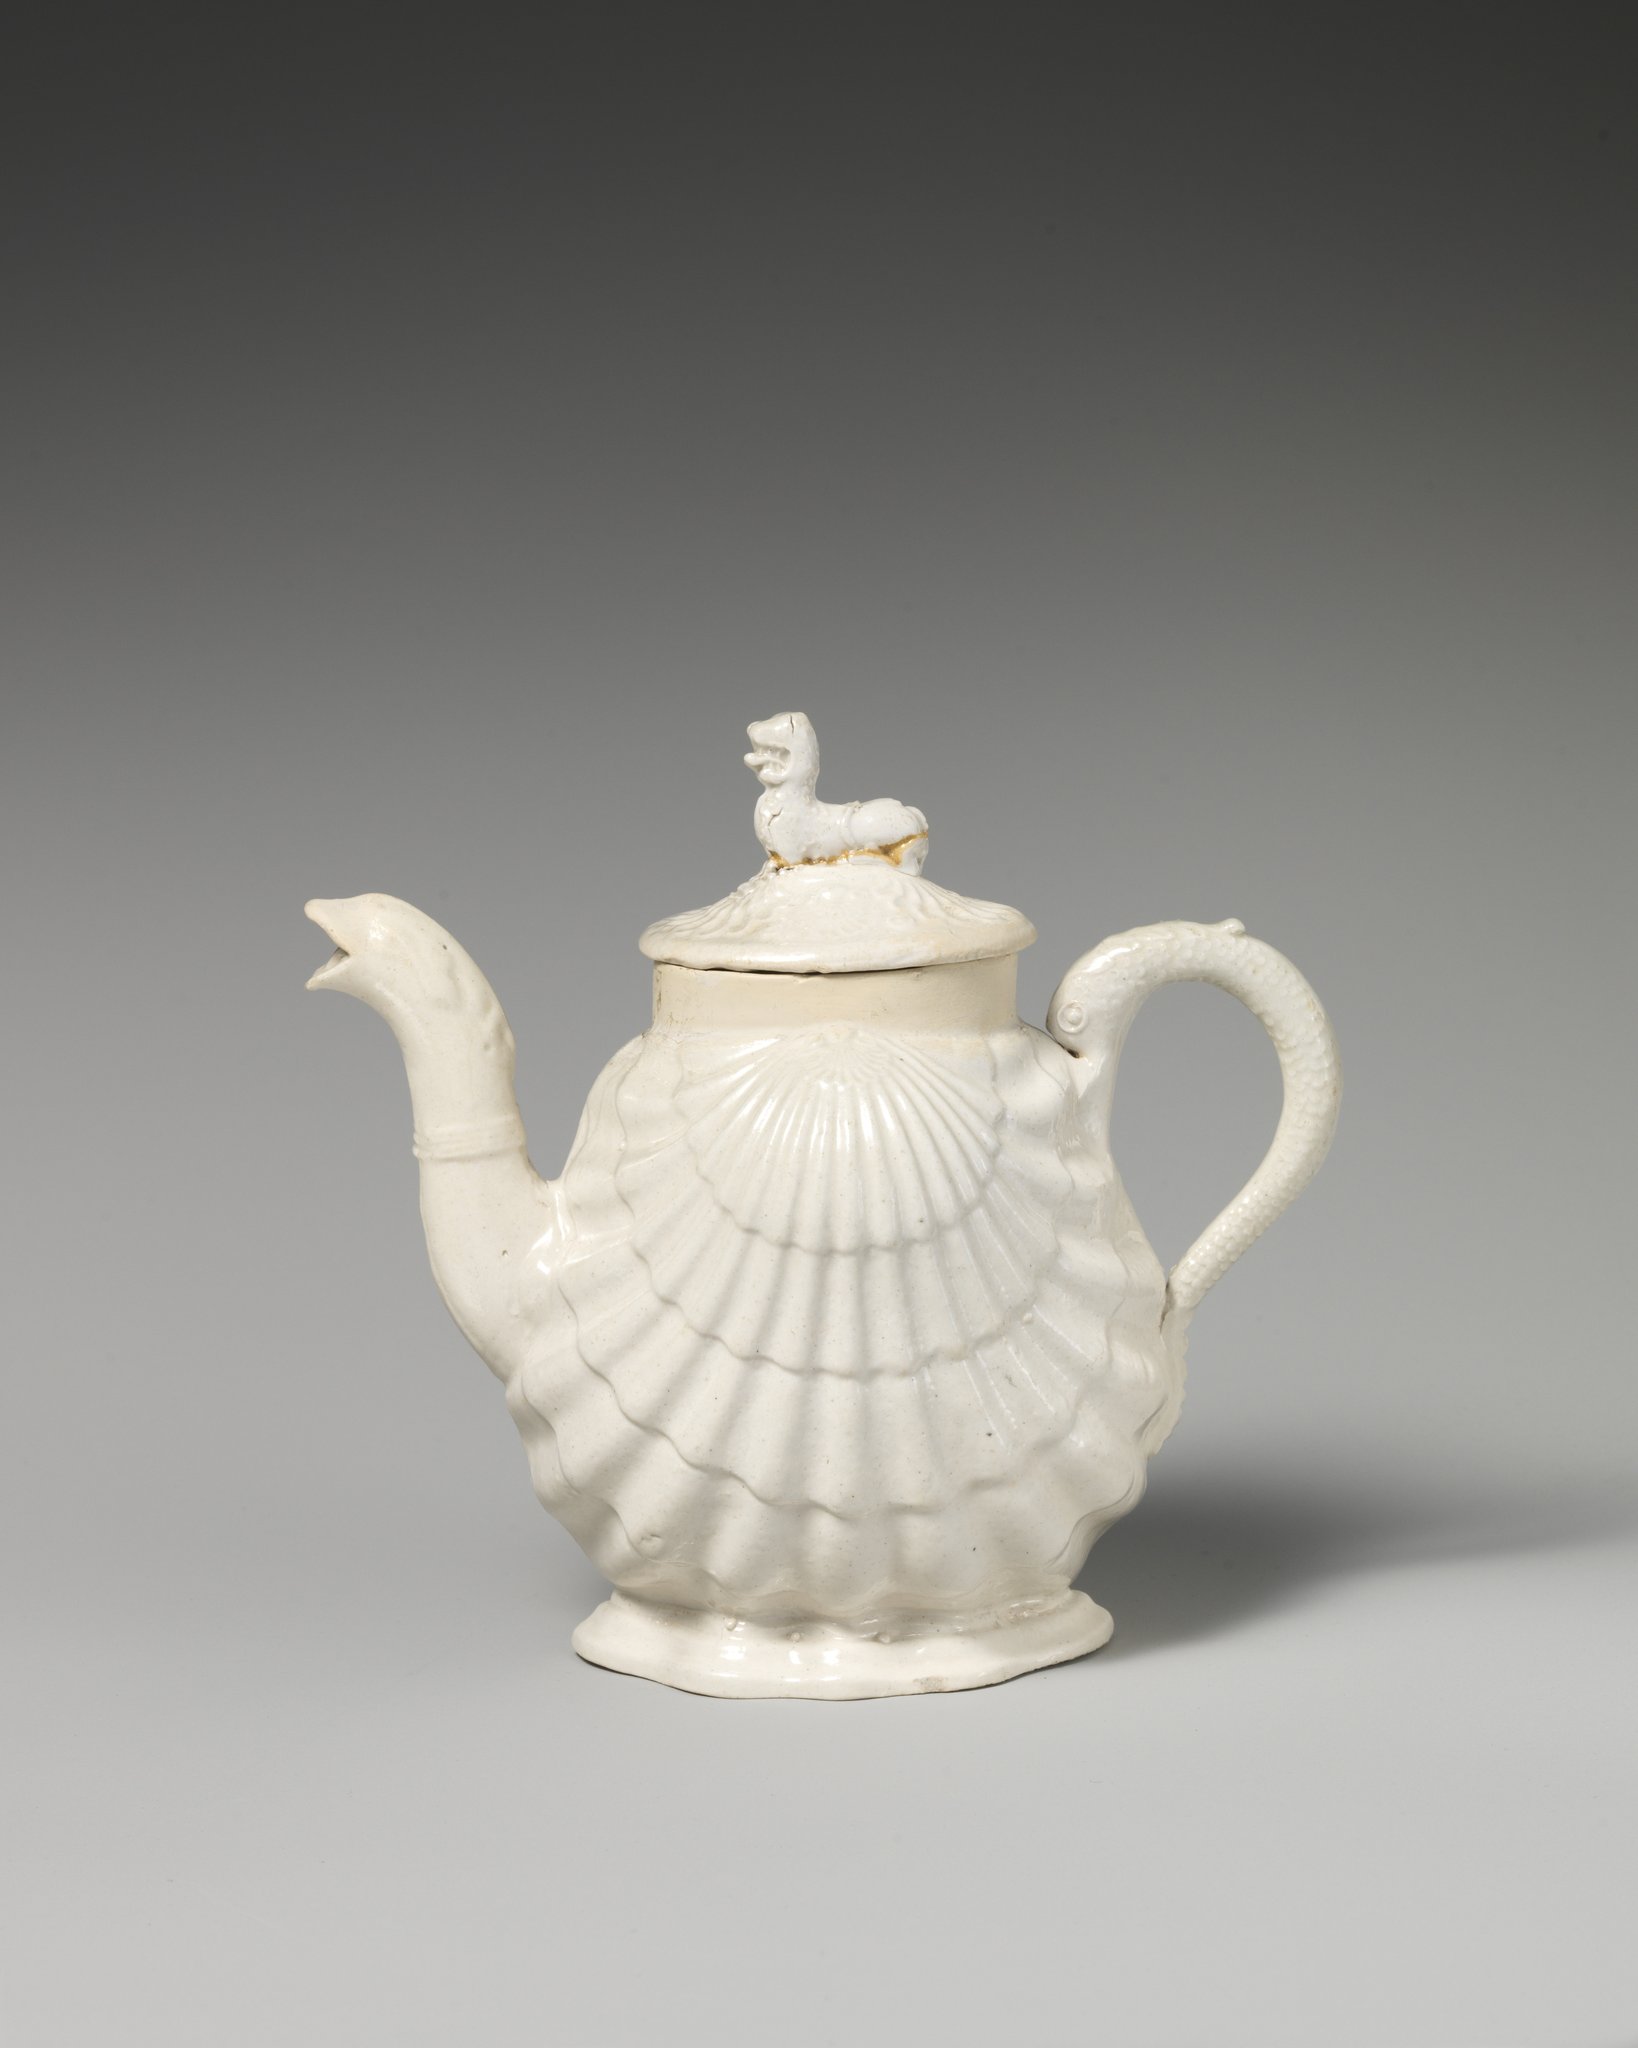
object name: teapot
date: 1745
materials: stoneware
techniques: salt glaze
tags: animals